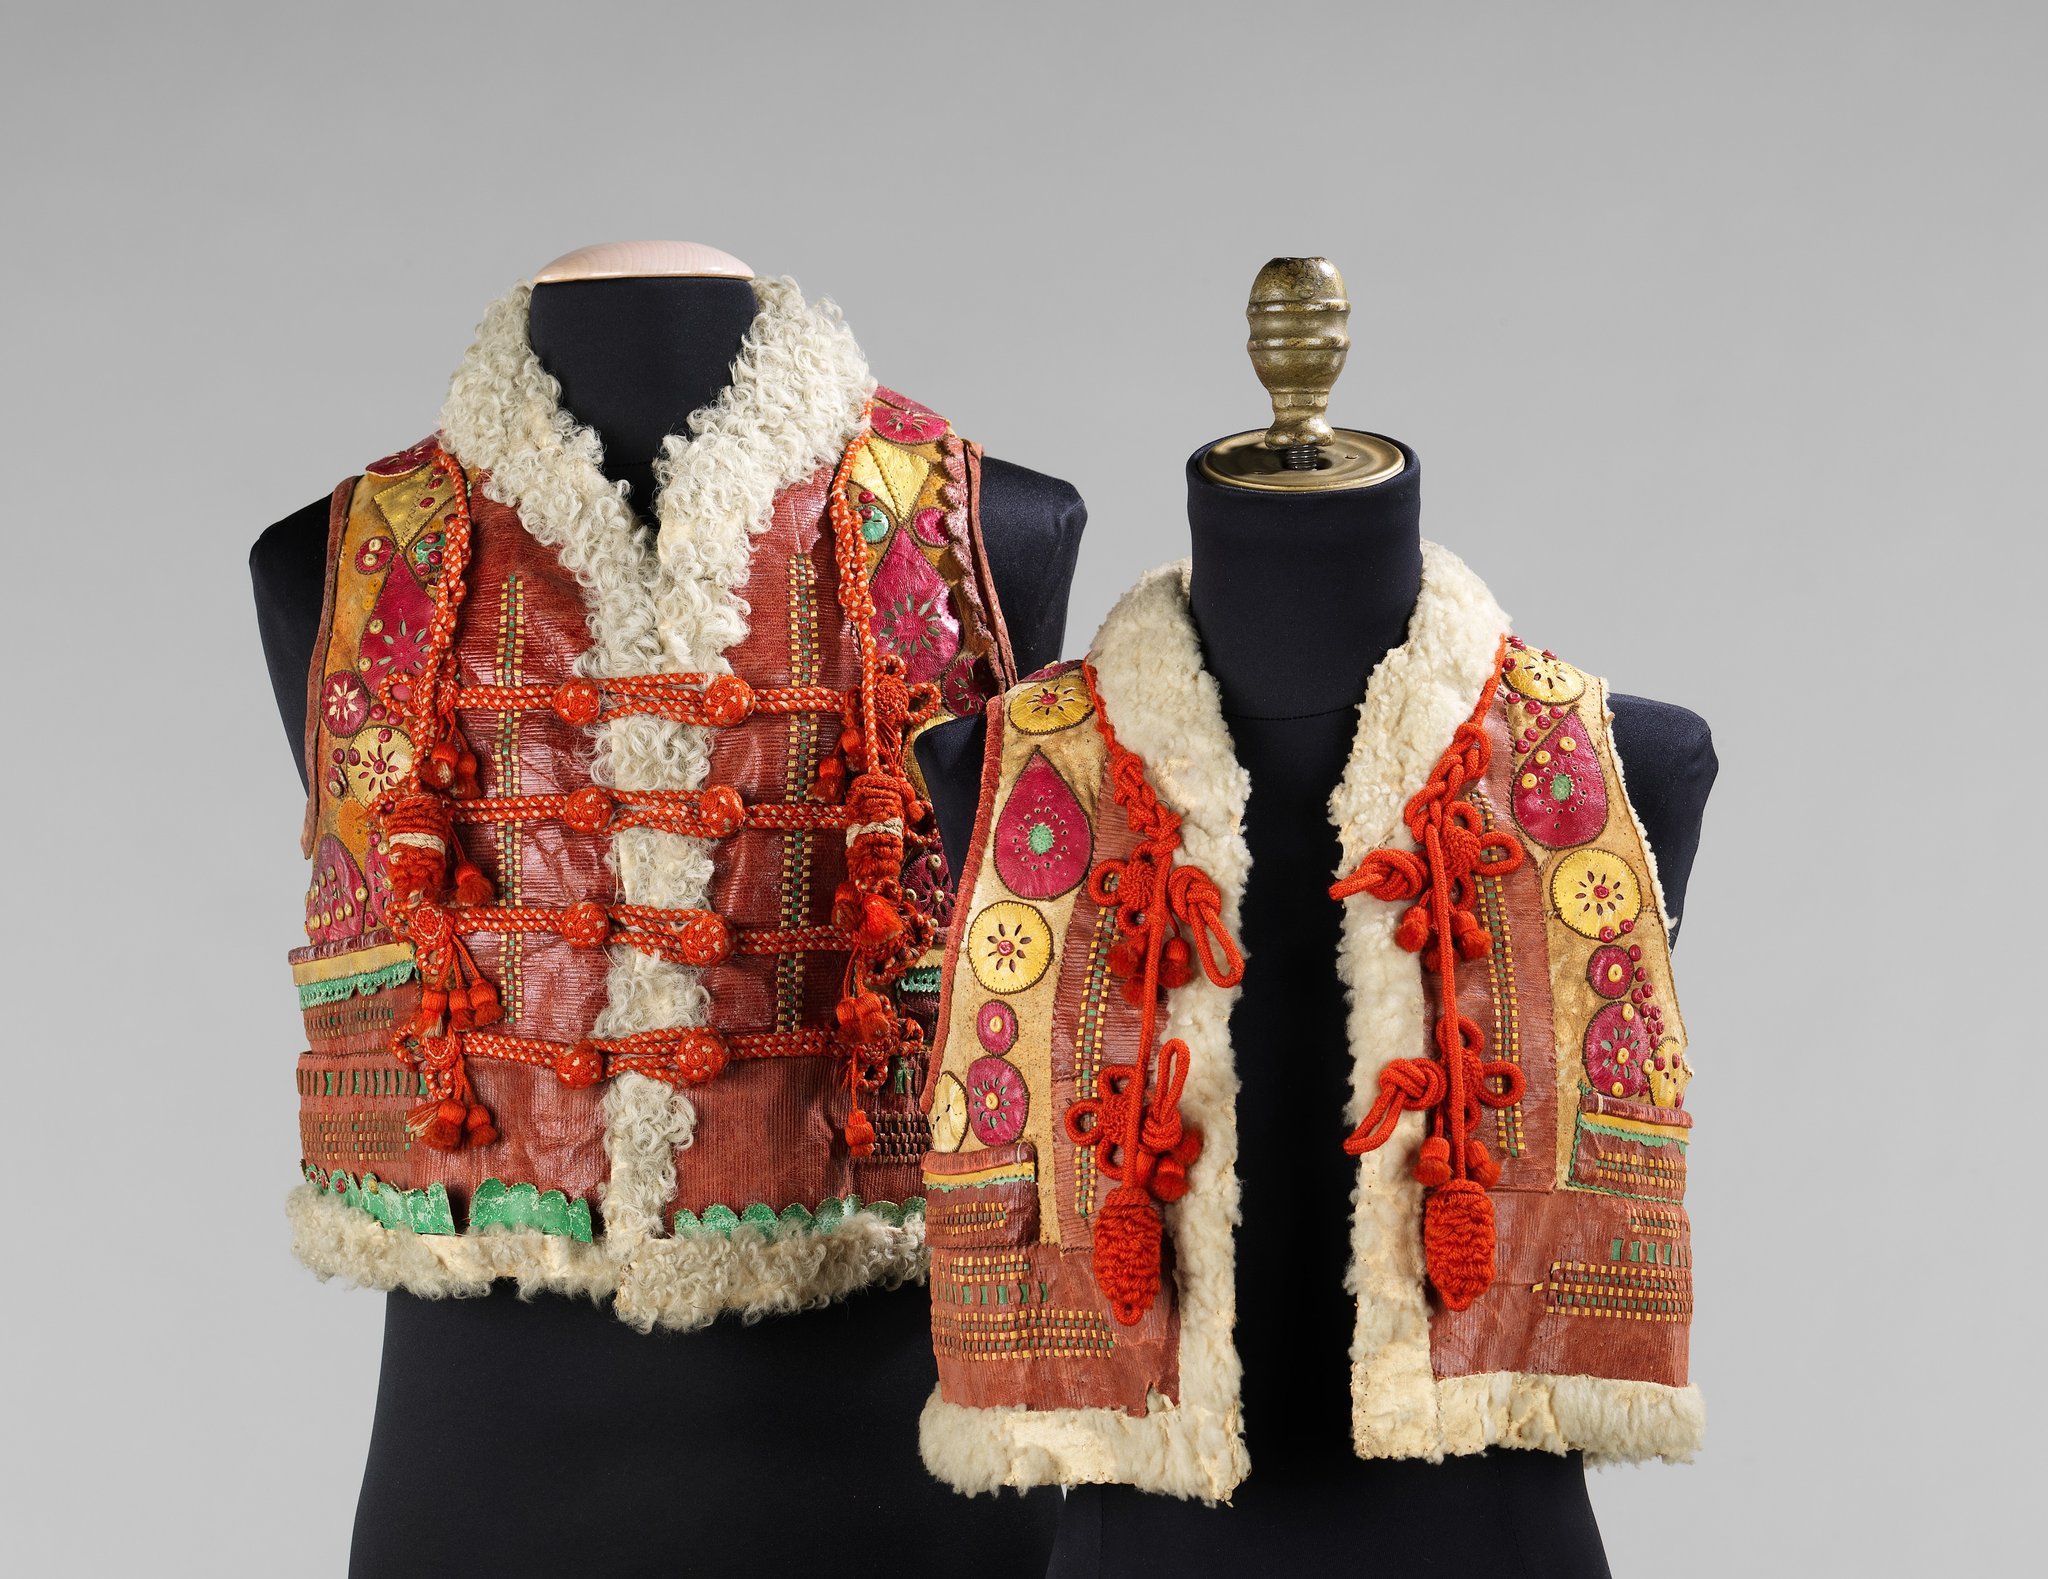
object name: vest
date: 1867-1900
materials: leather, wool